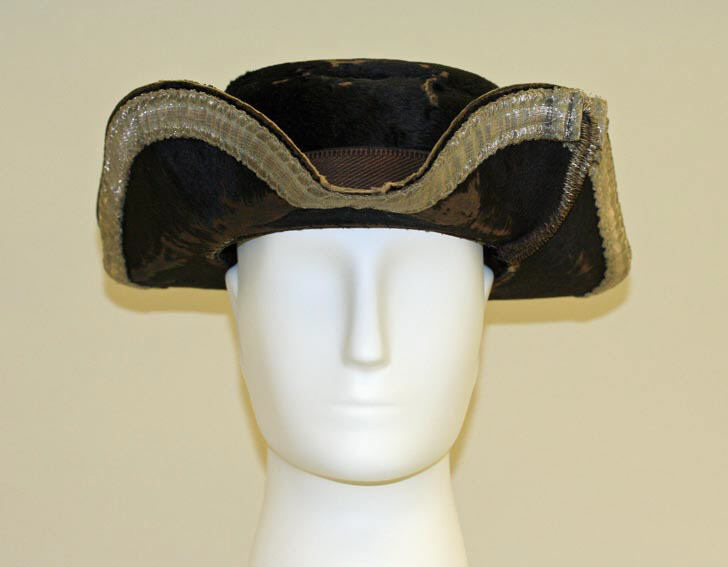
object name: tricorne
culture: european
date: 1767-1800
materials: wool